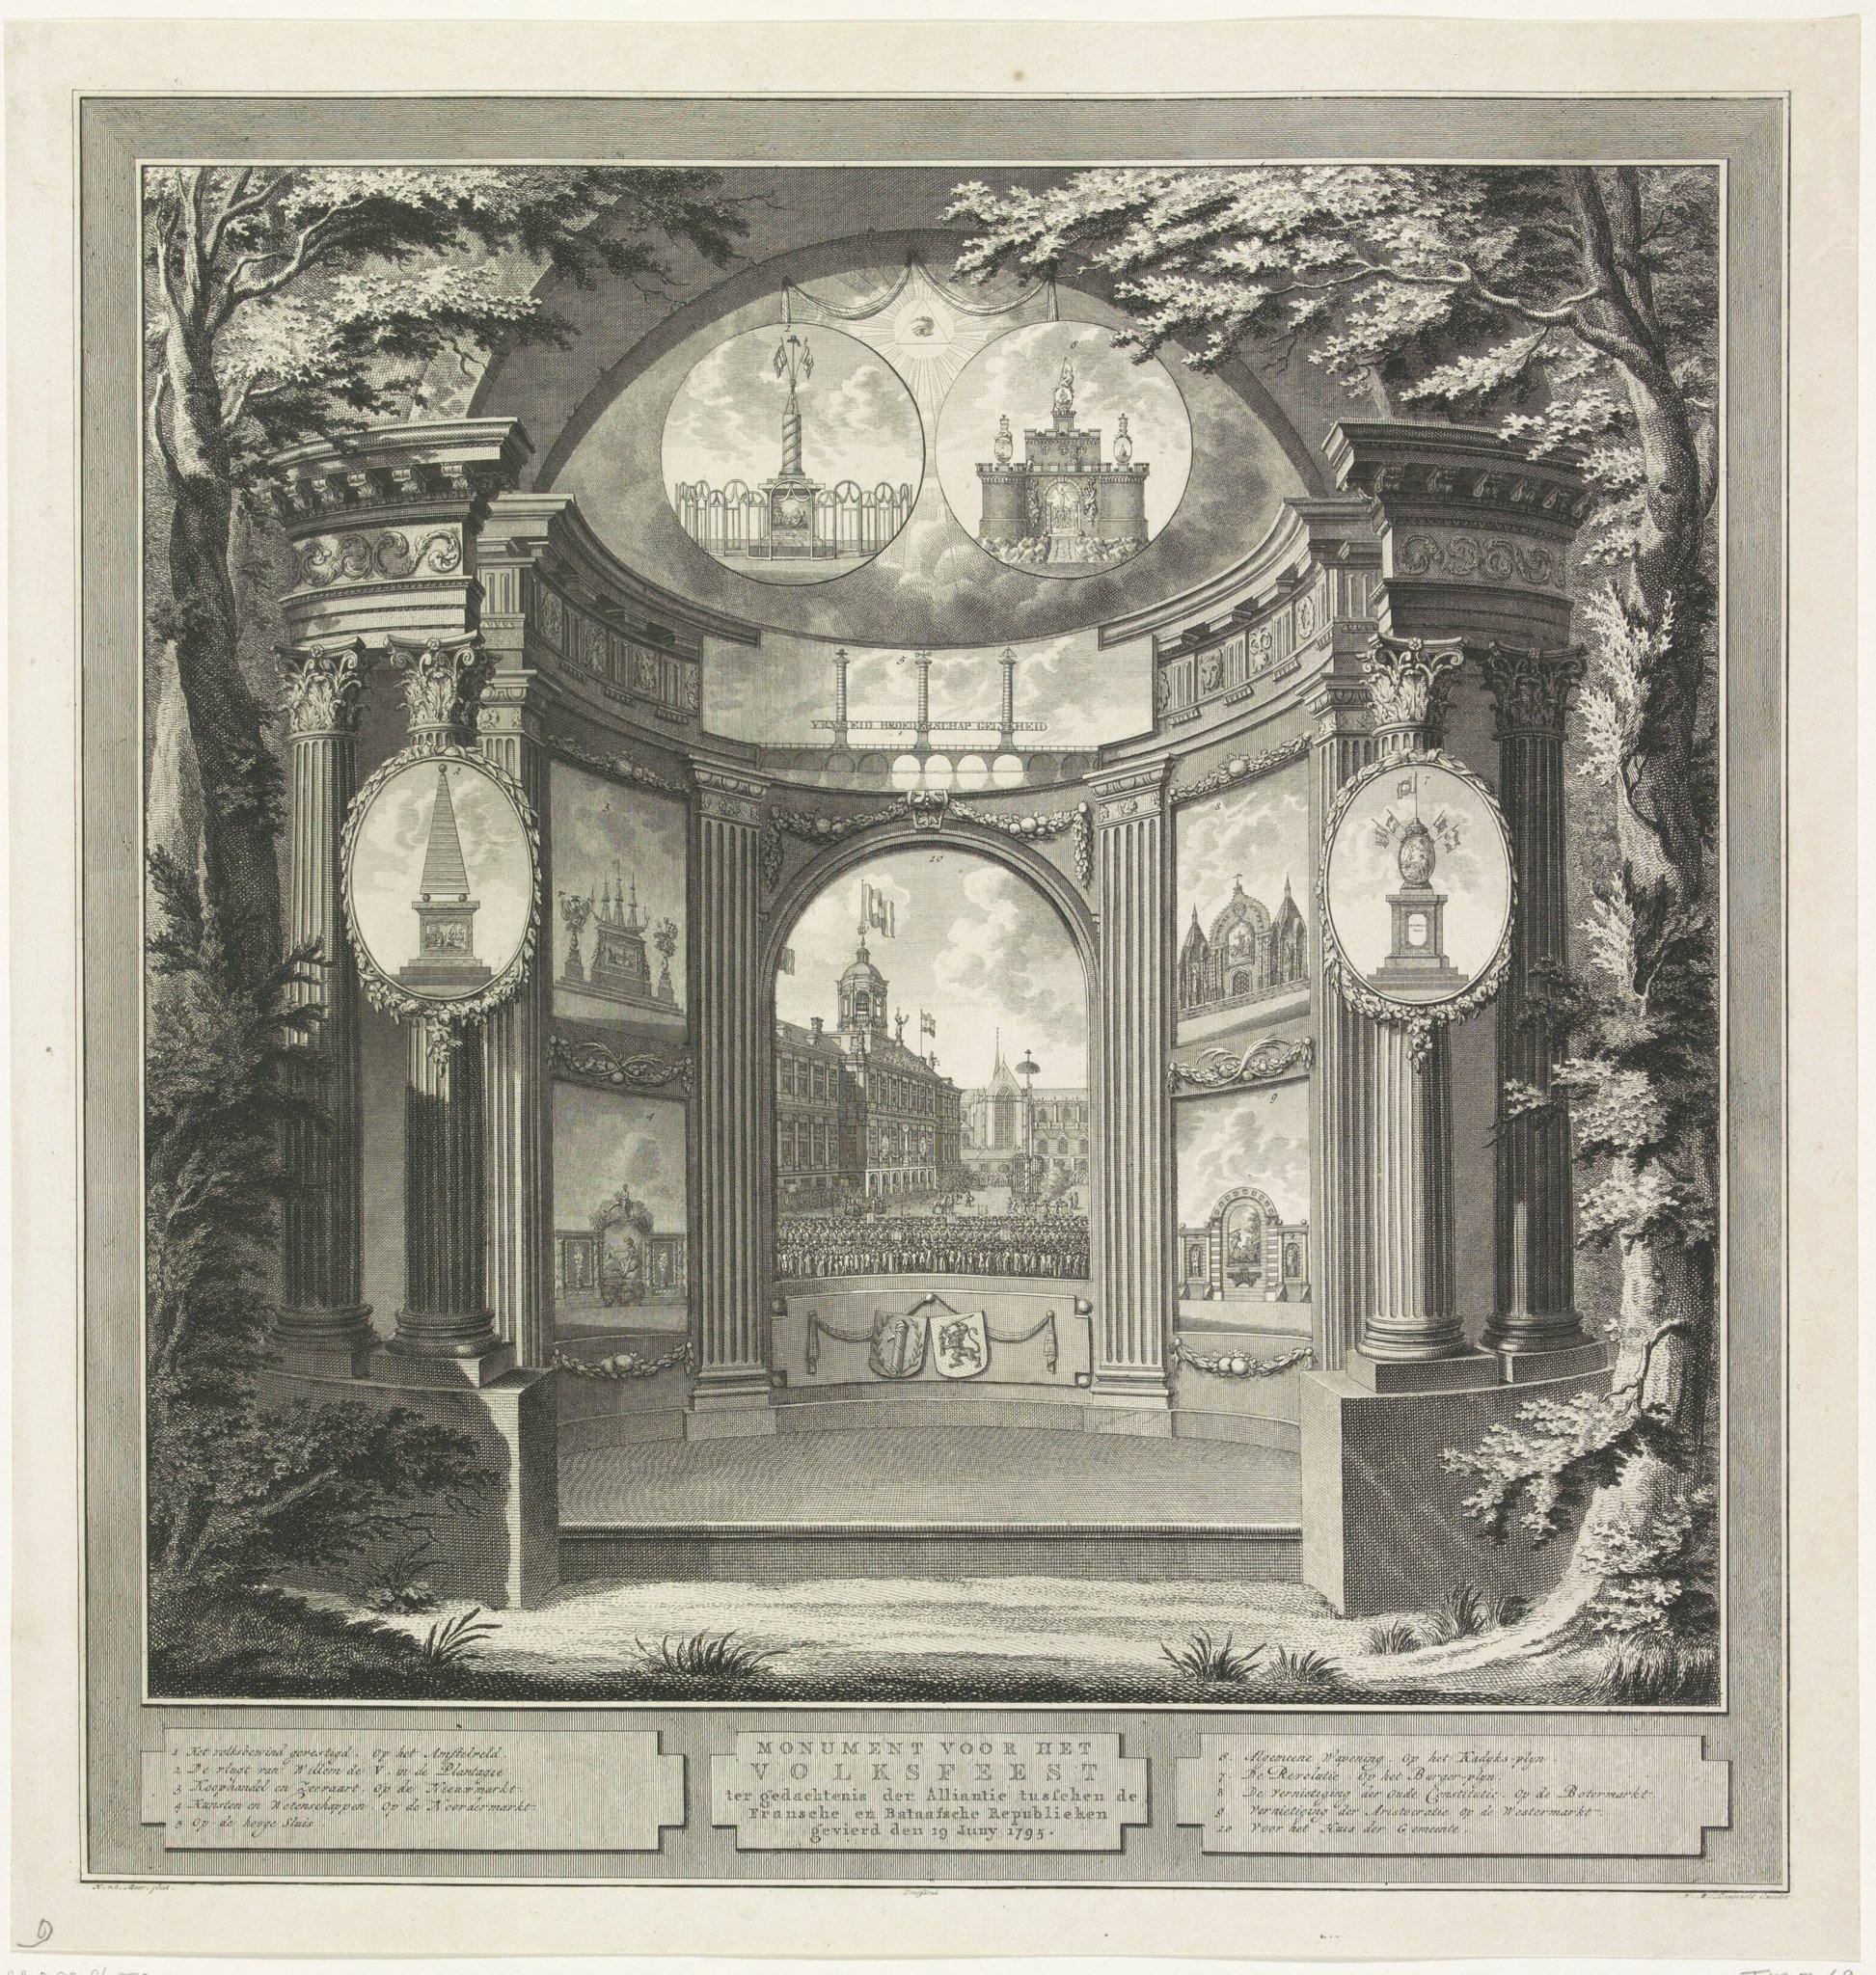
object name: print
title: Monument voor het Alliantiefeest te Amsterdam, 1795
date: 1795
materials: paper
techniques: engraving, etching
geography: amsterdam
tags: festivities on events of national importance (+ festive decoration ~ festive activities), alliance with france (1795)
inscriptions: collector's mark: Lugt 2228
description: Monument in de vorm van een tempel waarin zijn afgebeeld alle decoraties opgericht bij het Alliantiefeest te Amsterdam op 19 juni 1795. Centraal een gezicht op het volksfeest gevierd op de Dam voor het Stadhuis. Bij de prent behoort een prospectus.